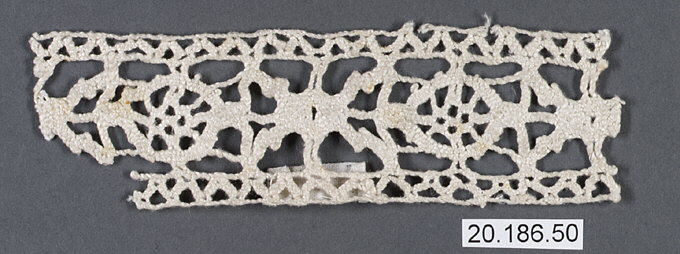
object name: insertion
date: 1501-1600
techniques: lace